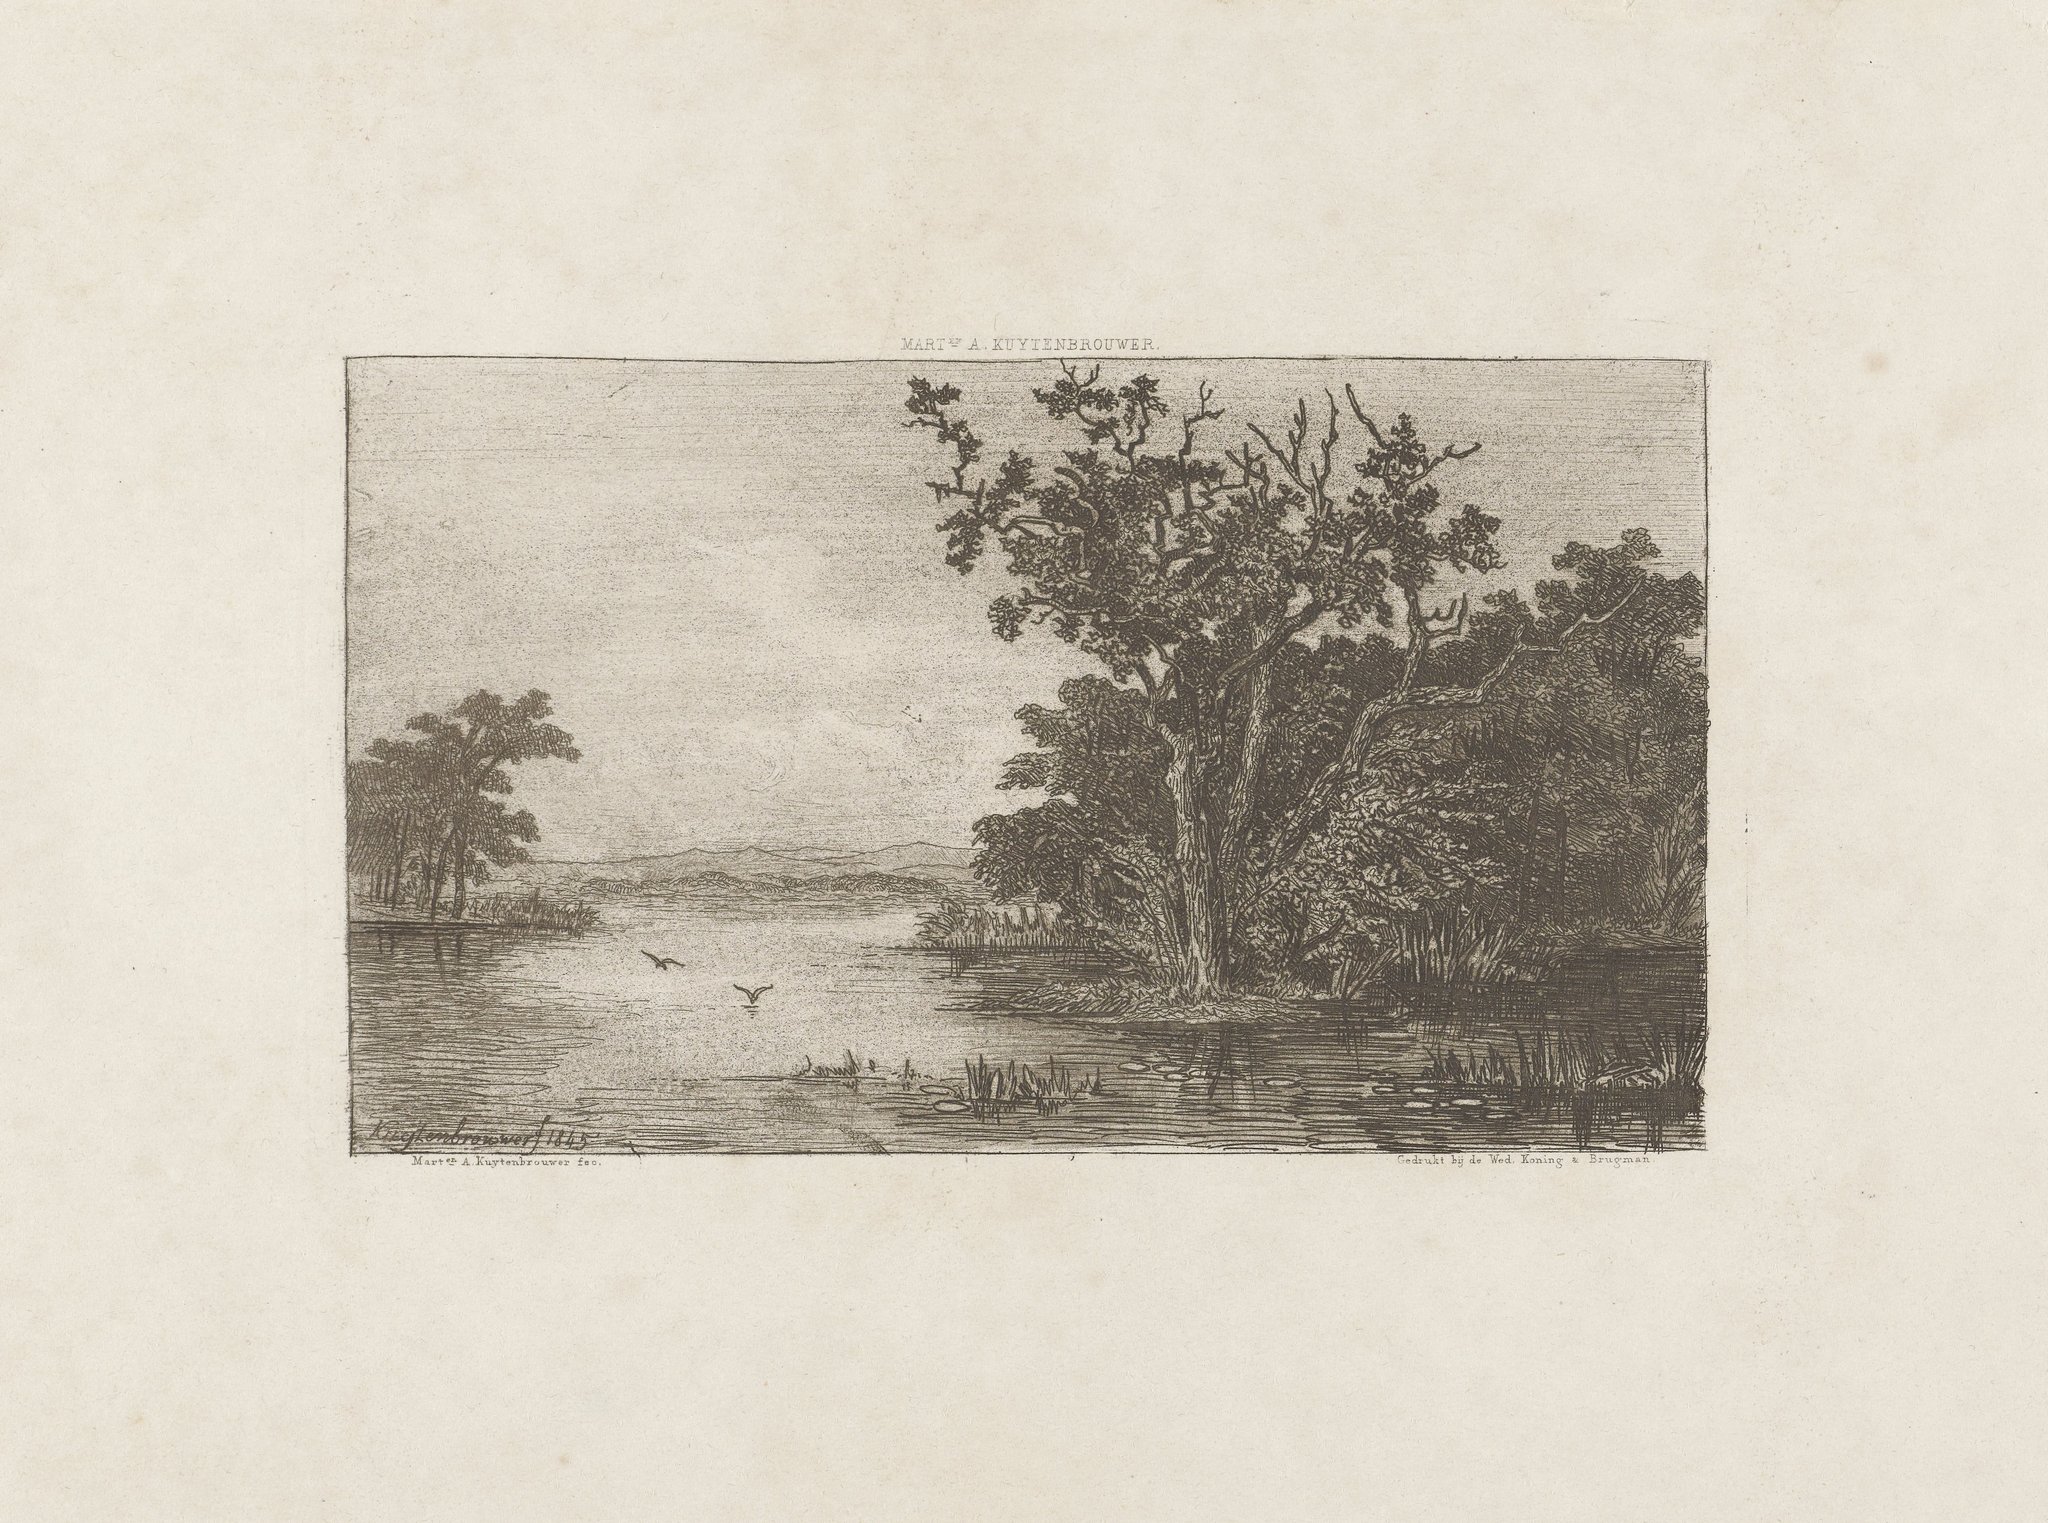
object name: print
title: Gezicht op een bosmeer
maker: martinus antonius kuytenbrouwer jr.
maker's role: draughtsman, painter, print maker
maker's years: 1821-1897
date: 1845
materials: paper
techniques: etching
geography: amsterdam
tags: birds, forest, wood, pond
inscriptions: collector's mark: Lugt 2228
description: Gezicht op een meer, aan de rand van een bos. Boven het meer twee vogels.